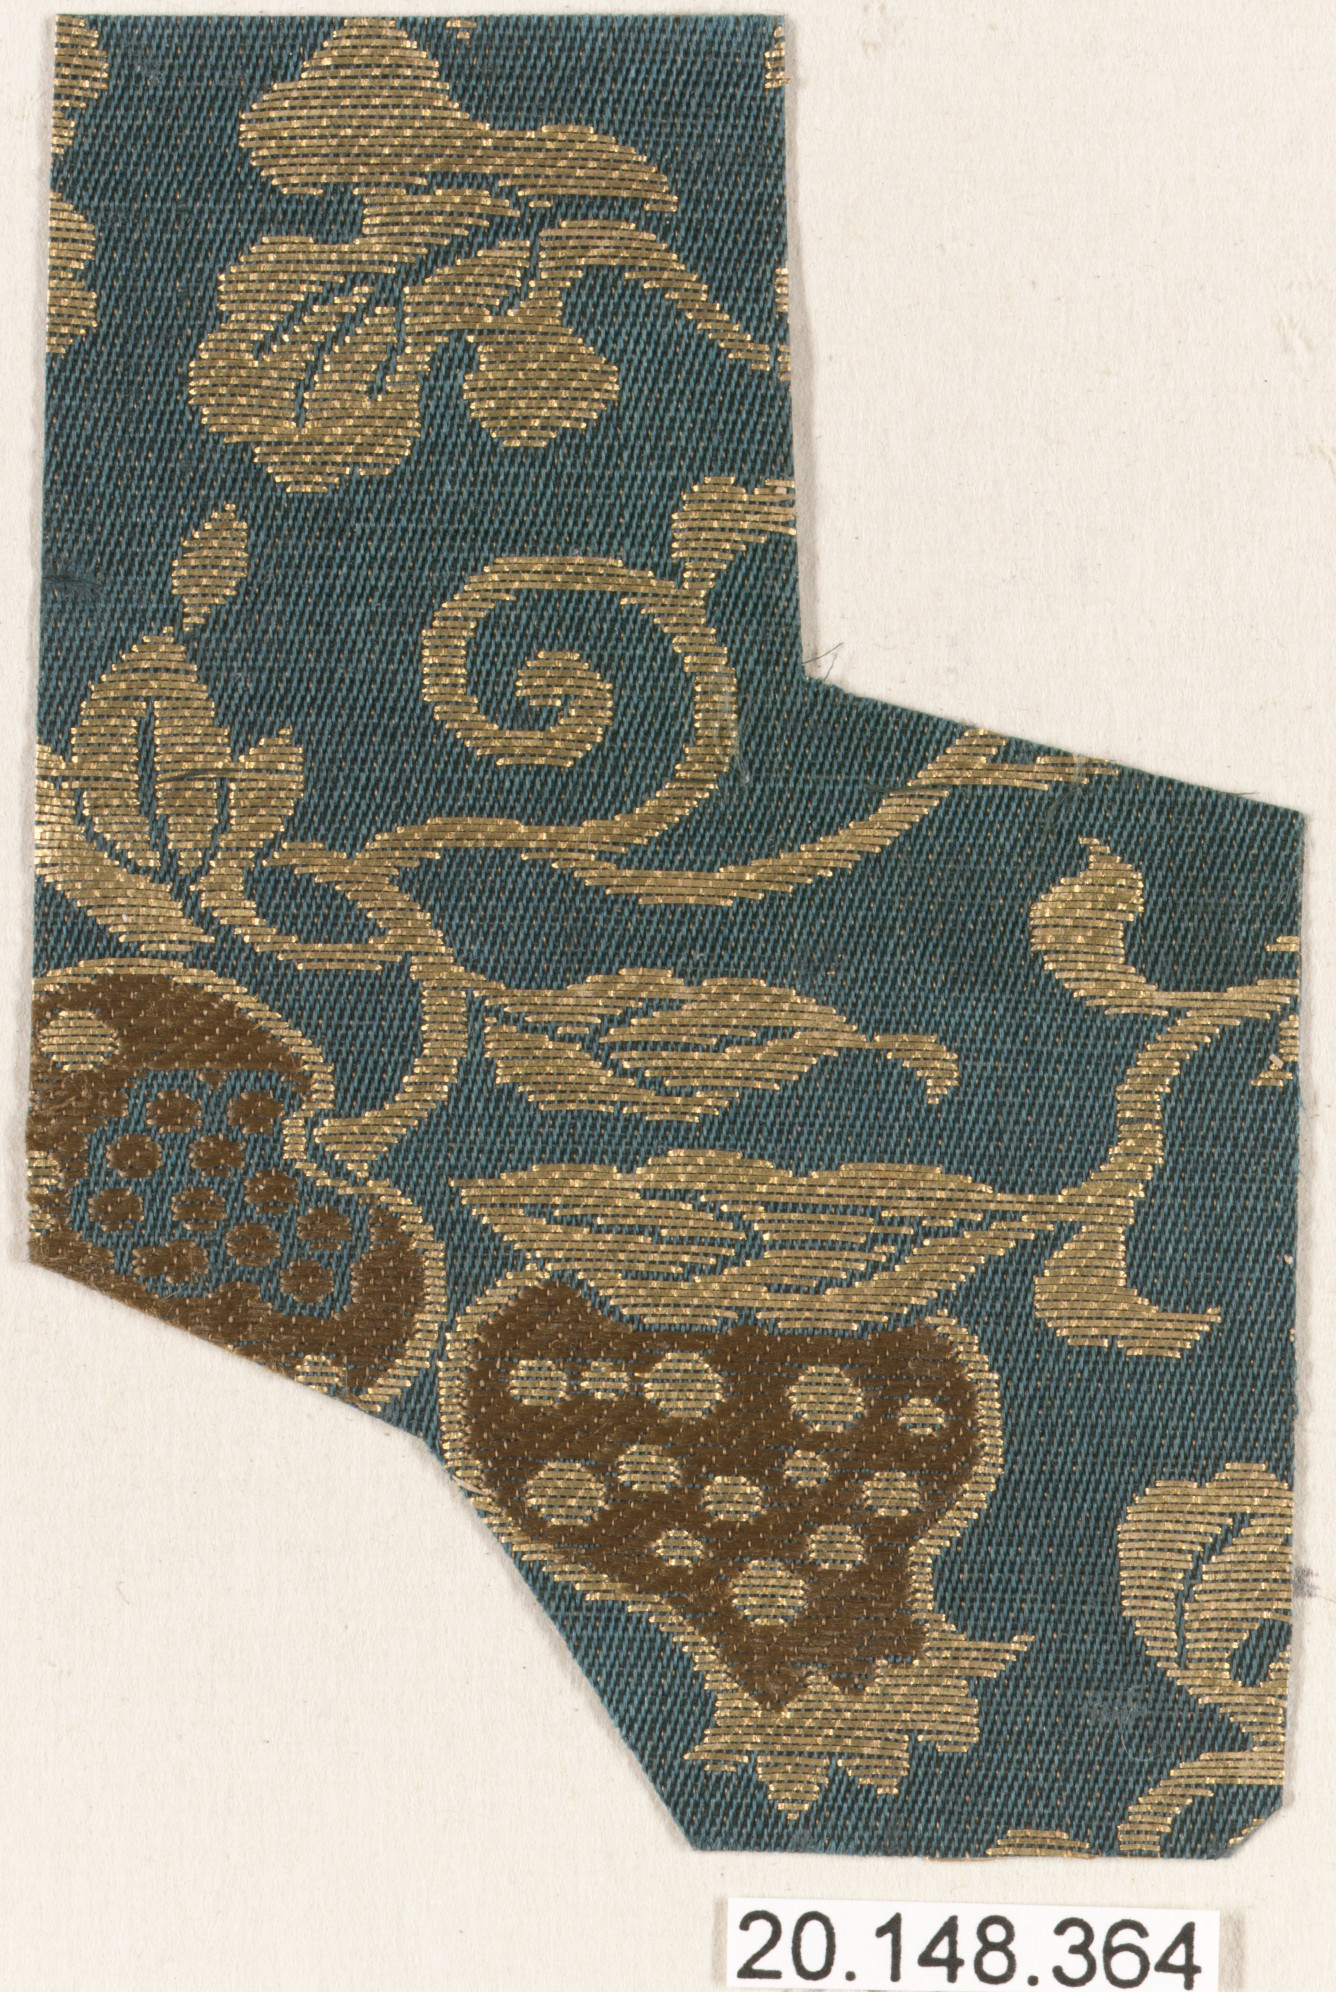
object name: piece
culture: japanese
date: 1701-1800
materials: silk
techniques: compound weave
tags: fruit,leaves